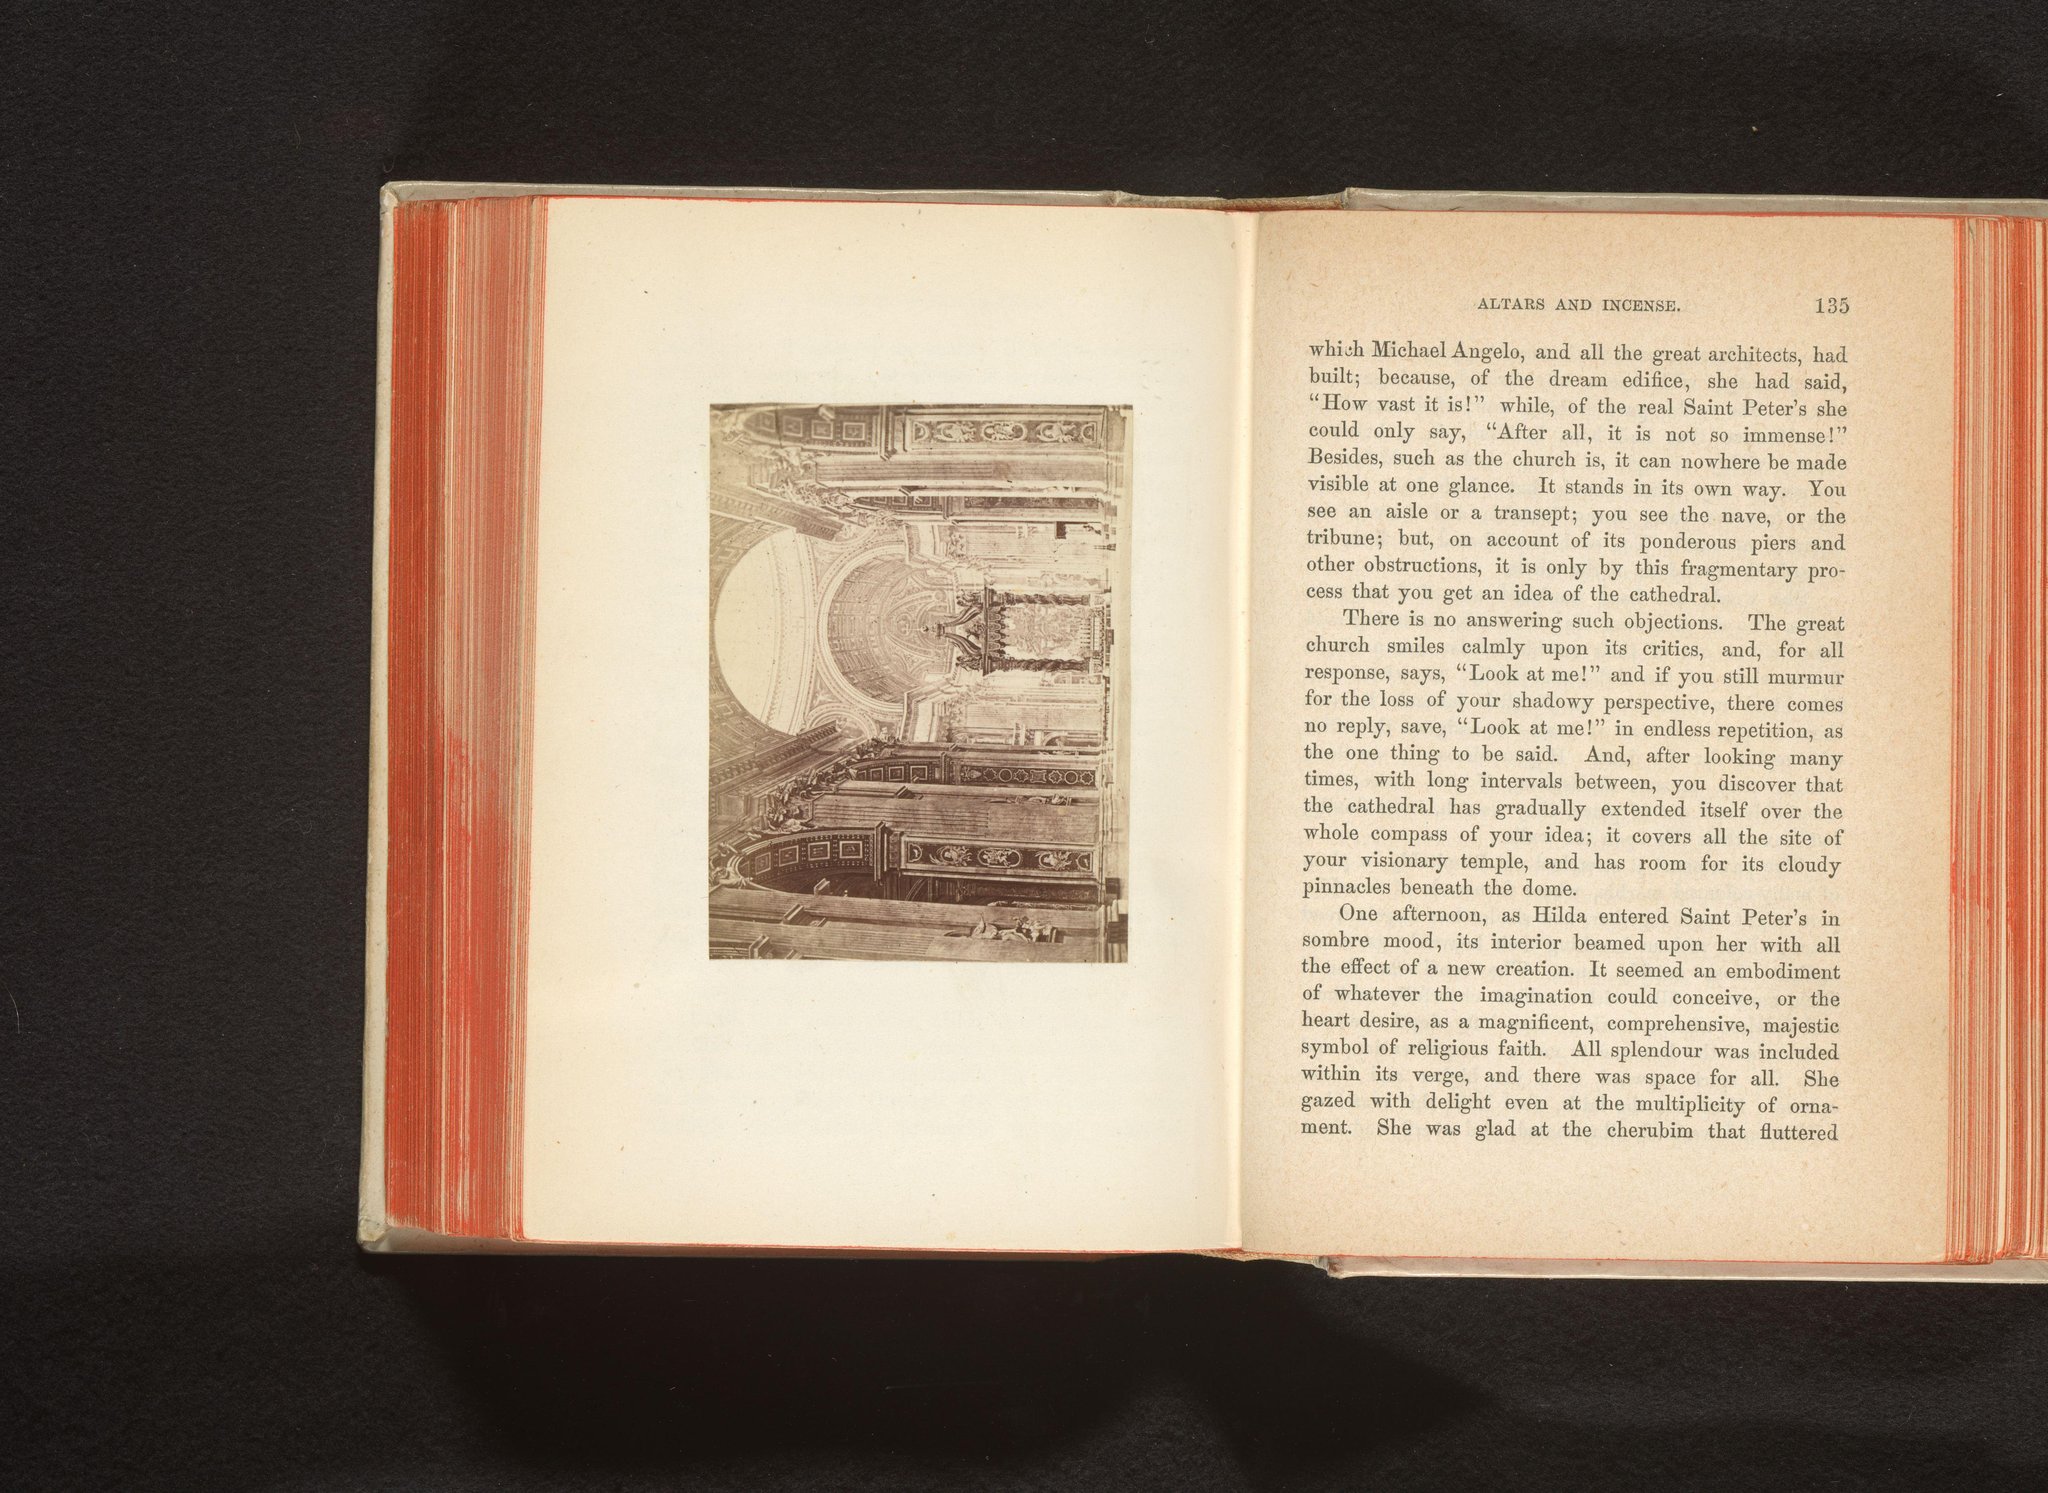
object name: photograph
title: Fotoreproductie van een tekening van het interieur van de Sint-Pietersbasiliek in Vaticaanstad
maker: Anonymous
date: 1850-1860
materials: photographic support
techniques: albumen print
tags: interior of church